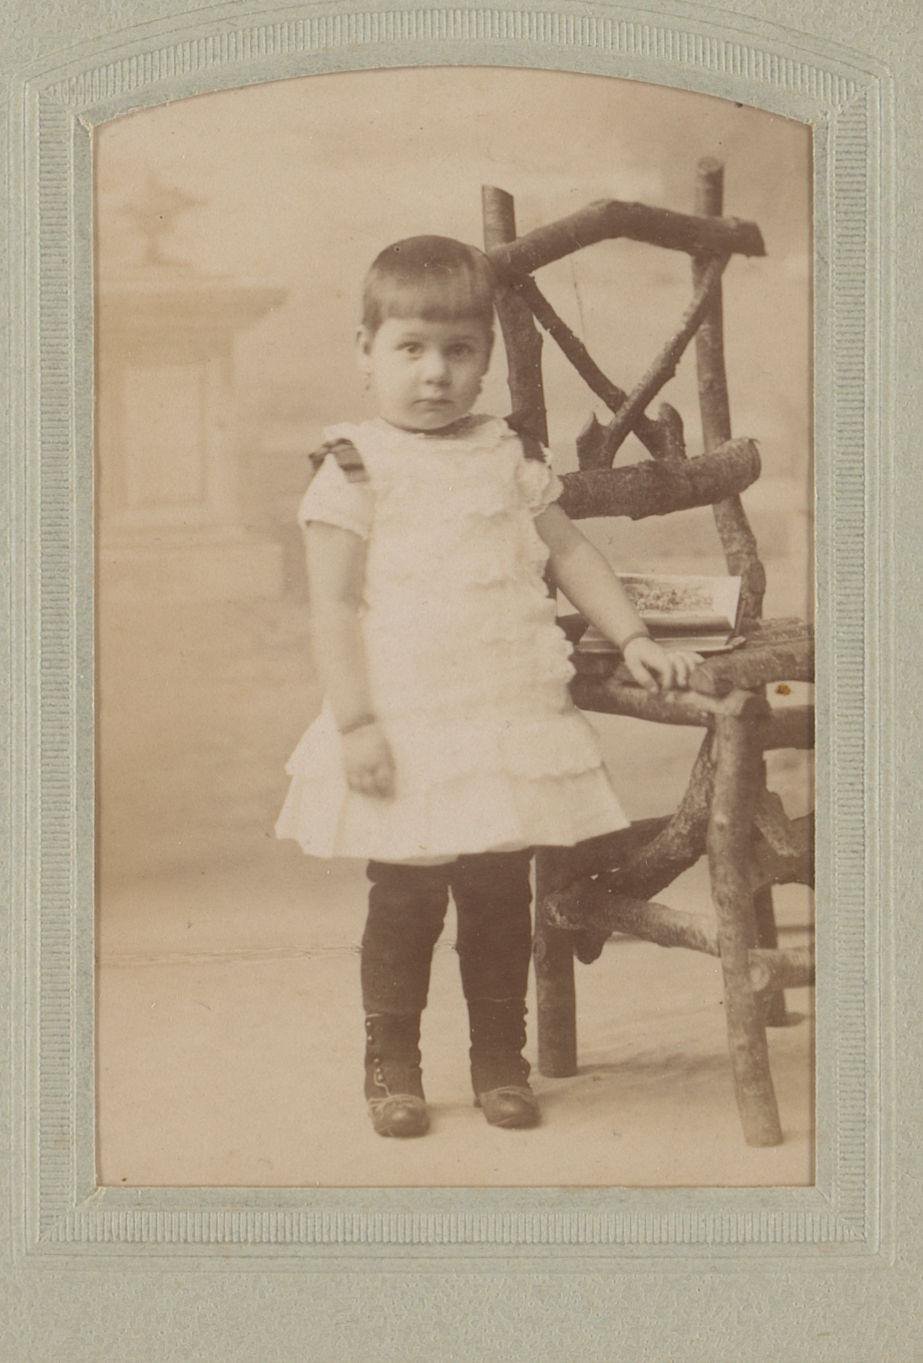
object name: carte de visite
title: Portret van een meisje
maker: albert greiner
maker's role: fotograaf, fotostudio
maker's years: 1833-1890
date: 1890-1910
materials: cardboard, photographic support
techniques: albumen print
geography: amsterdam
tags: historical persons, girl (child between toddler and youth)